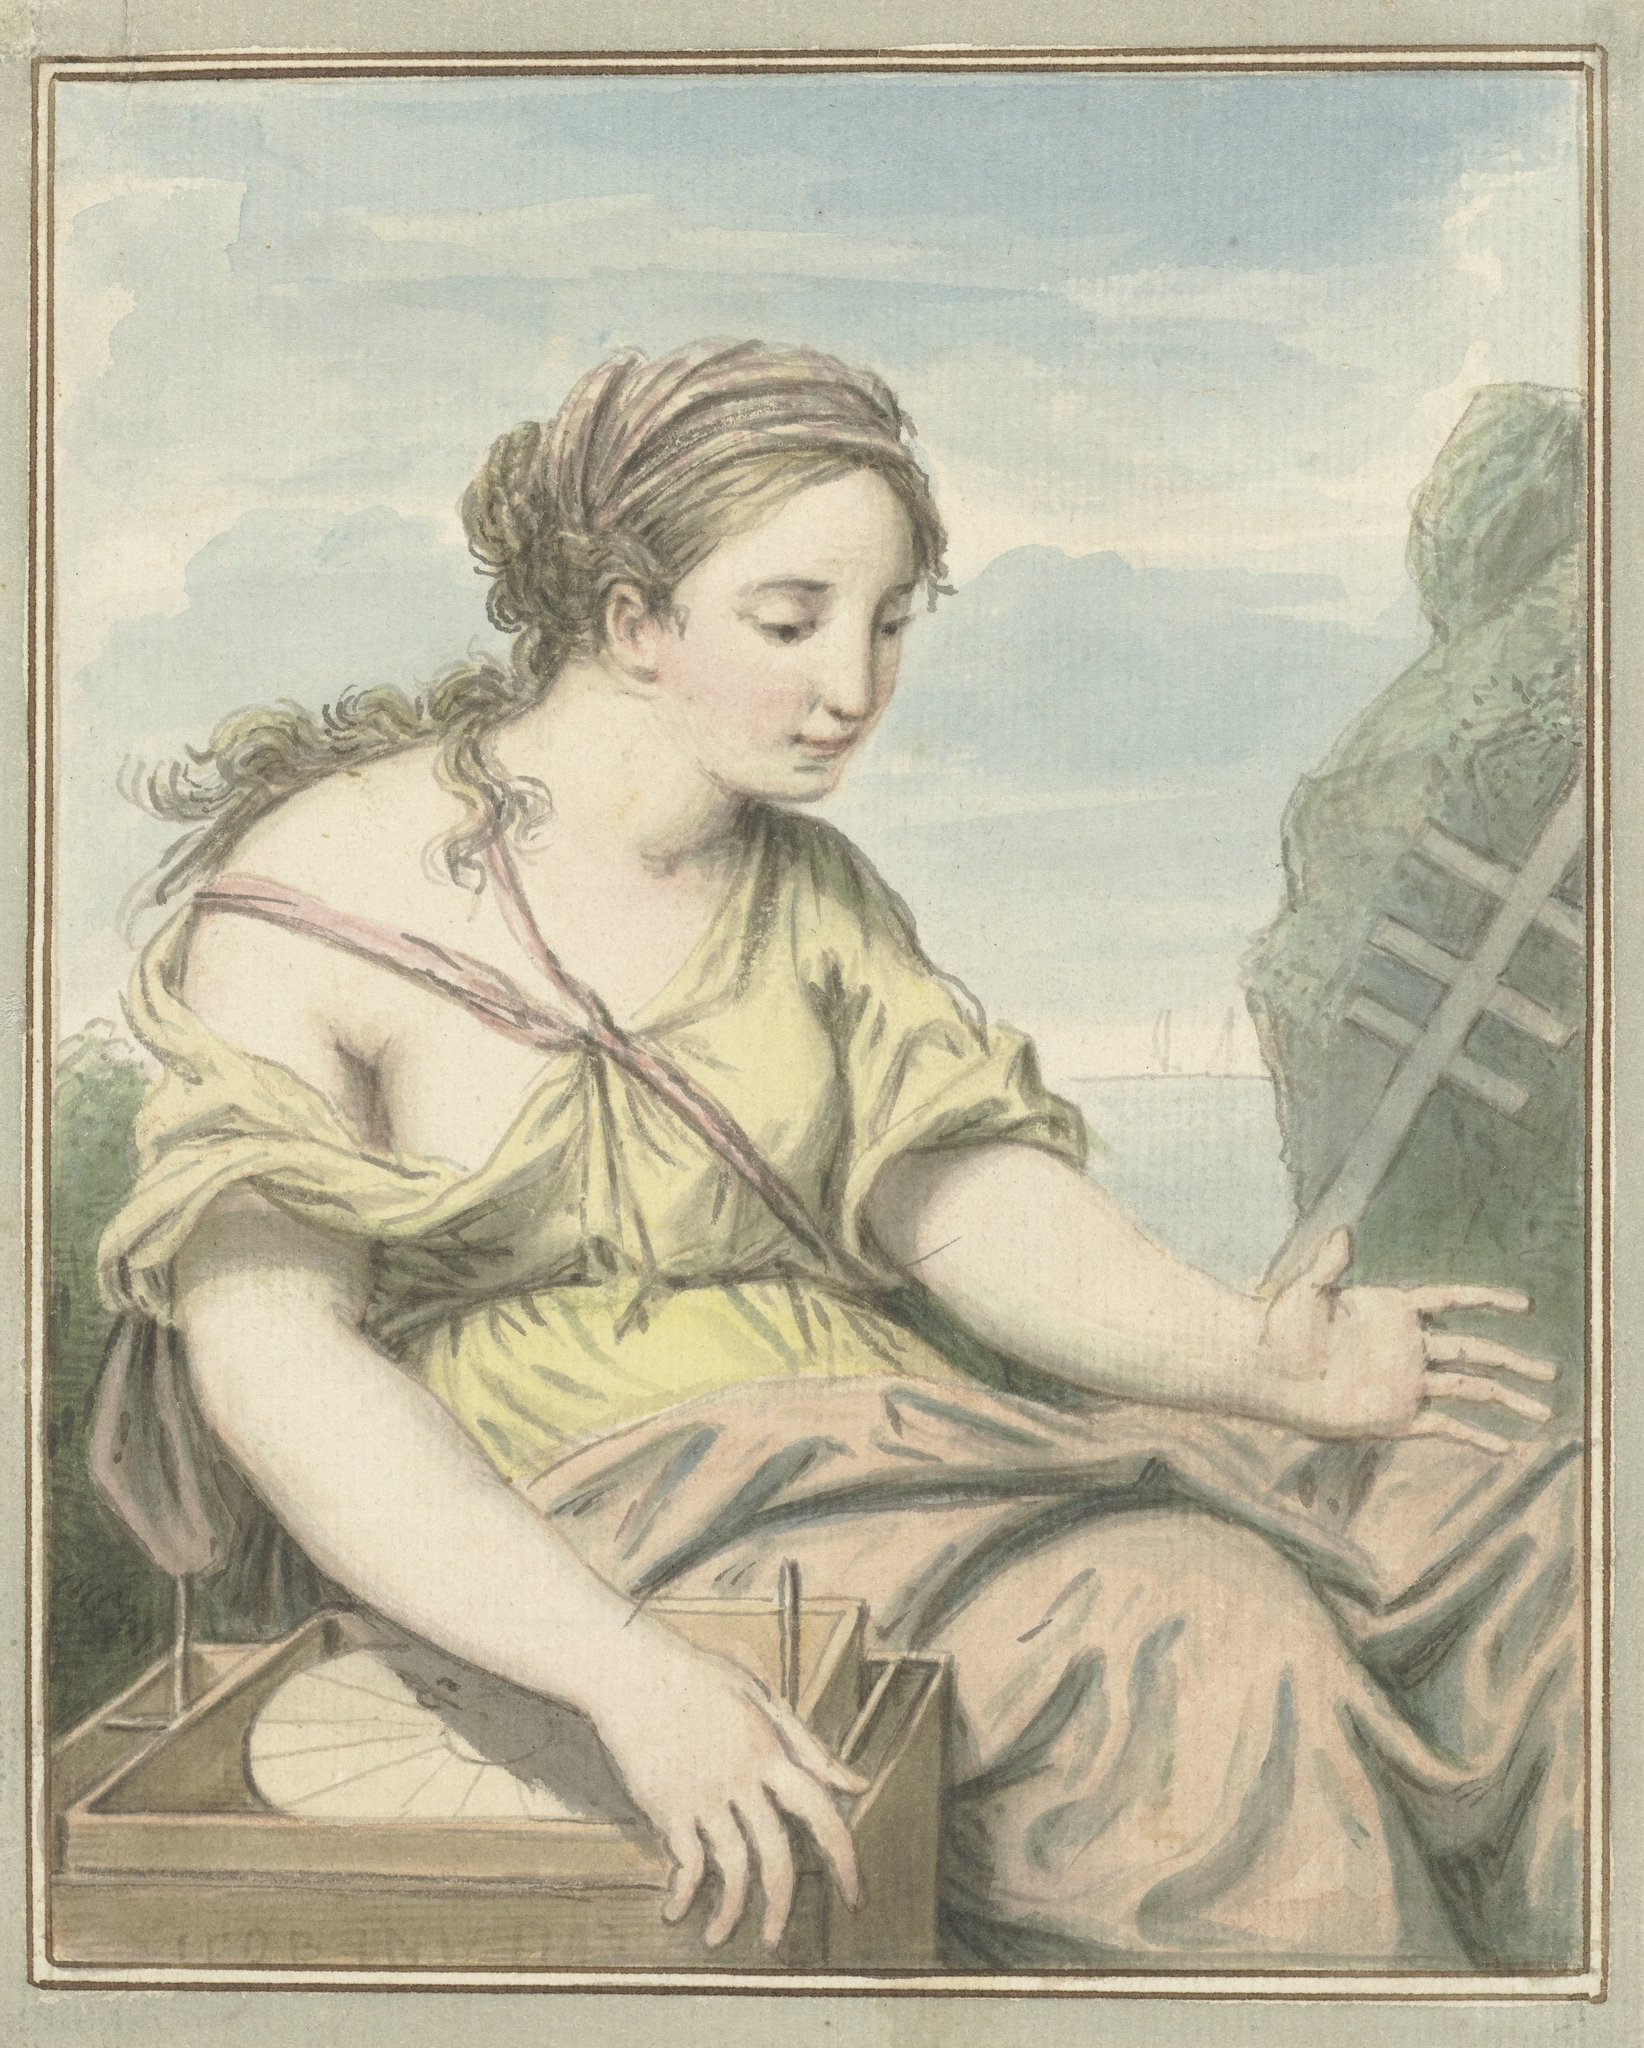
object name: drawing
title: De Zeevaart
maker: louis fabritius dubourg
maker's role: draughtsman, print maker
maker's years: 1693-1775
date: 1743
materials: chalk, ink, paper, watercolor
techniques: brush, pen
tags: 'navigatione' (ripa)